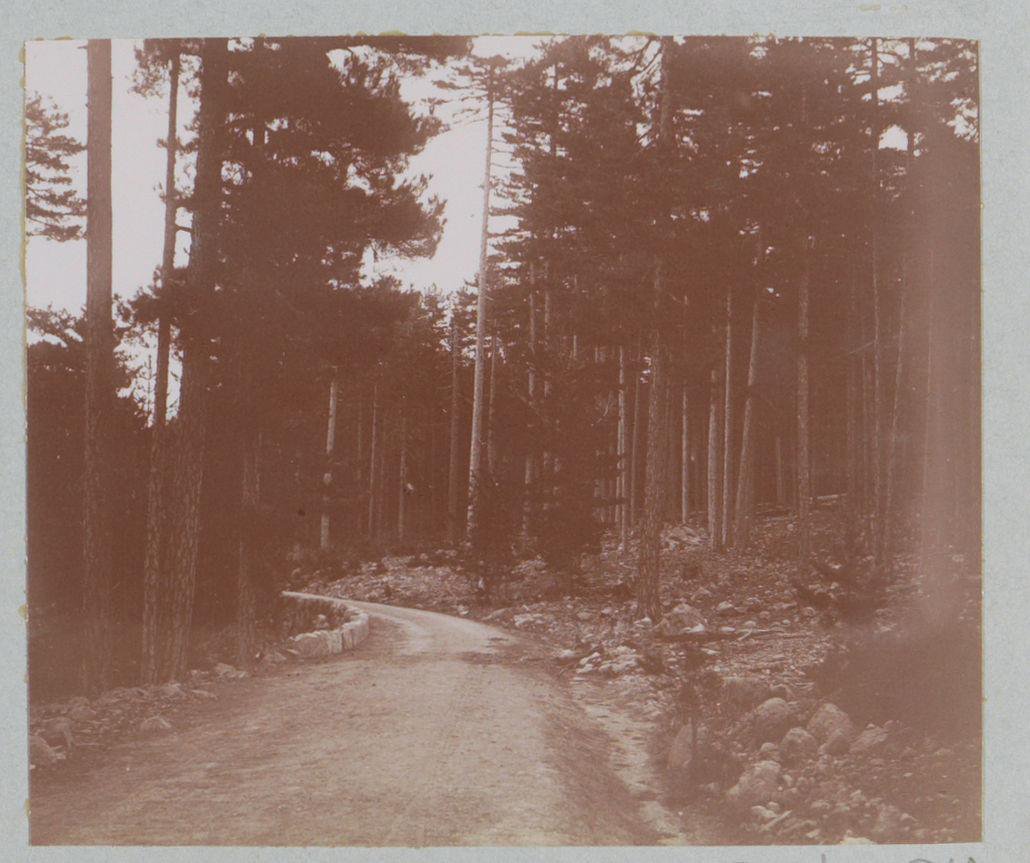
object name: photograph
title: Weg door een dennenbos op Corsica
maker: Anonymous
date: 1905-1910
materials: paper, photographic support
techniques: gelatin silver print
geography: corsica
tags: road, path, forest, wood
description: Onderdeel van Fotoalbum van een Franse amateurfotograaf met bezienswaardigheden in Frankrijk, Zwitserland en Italië.